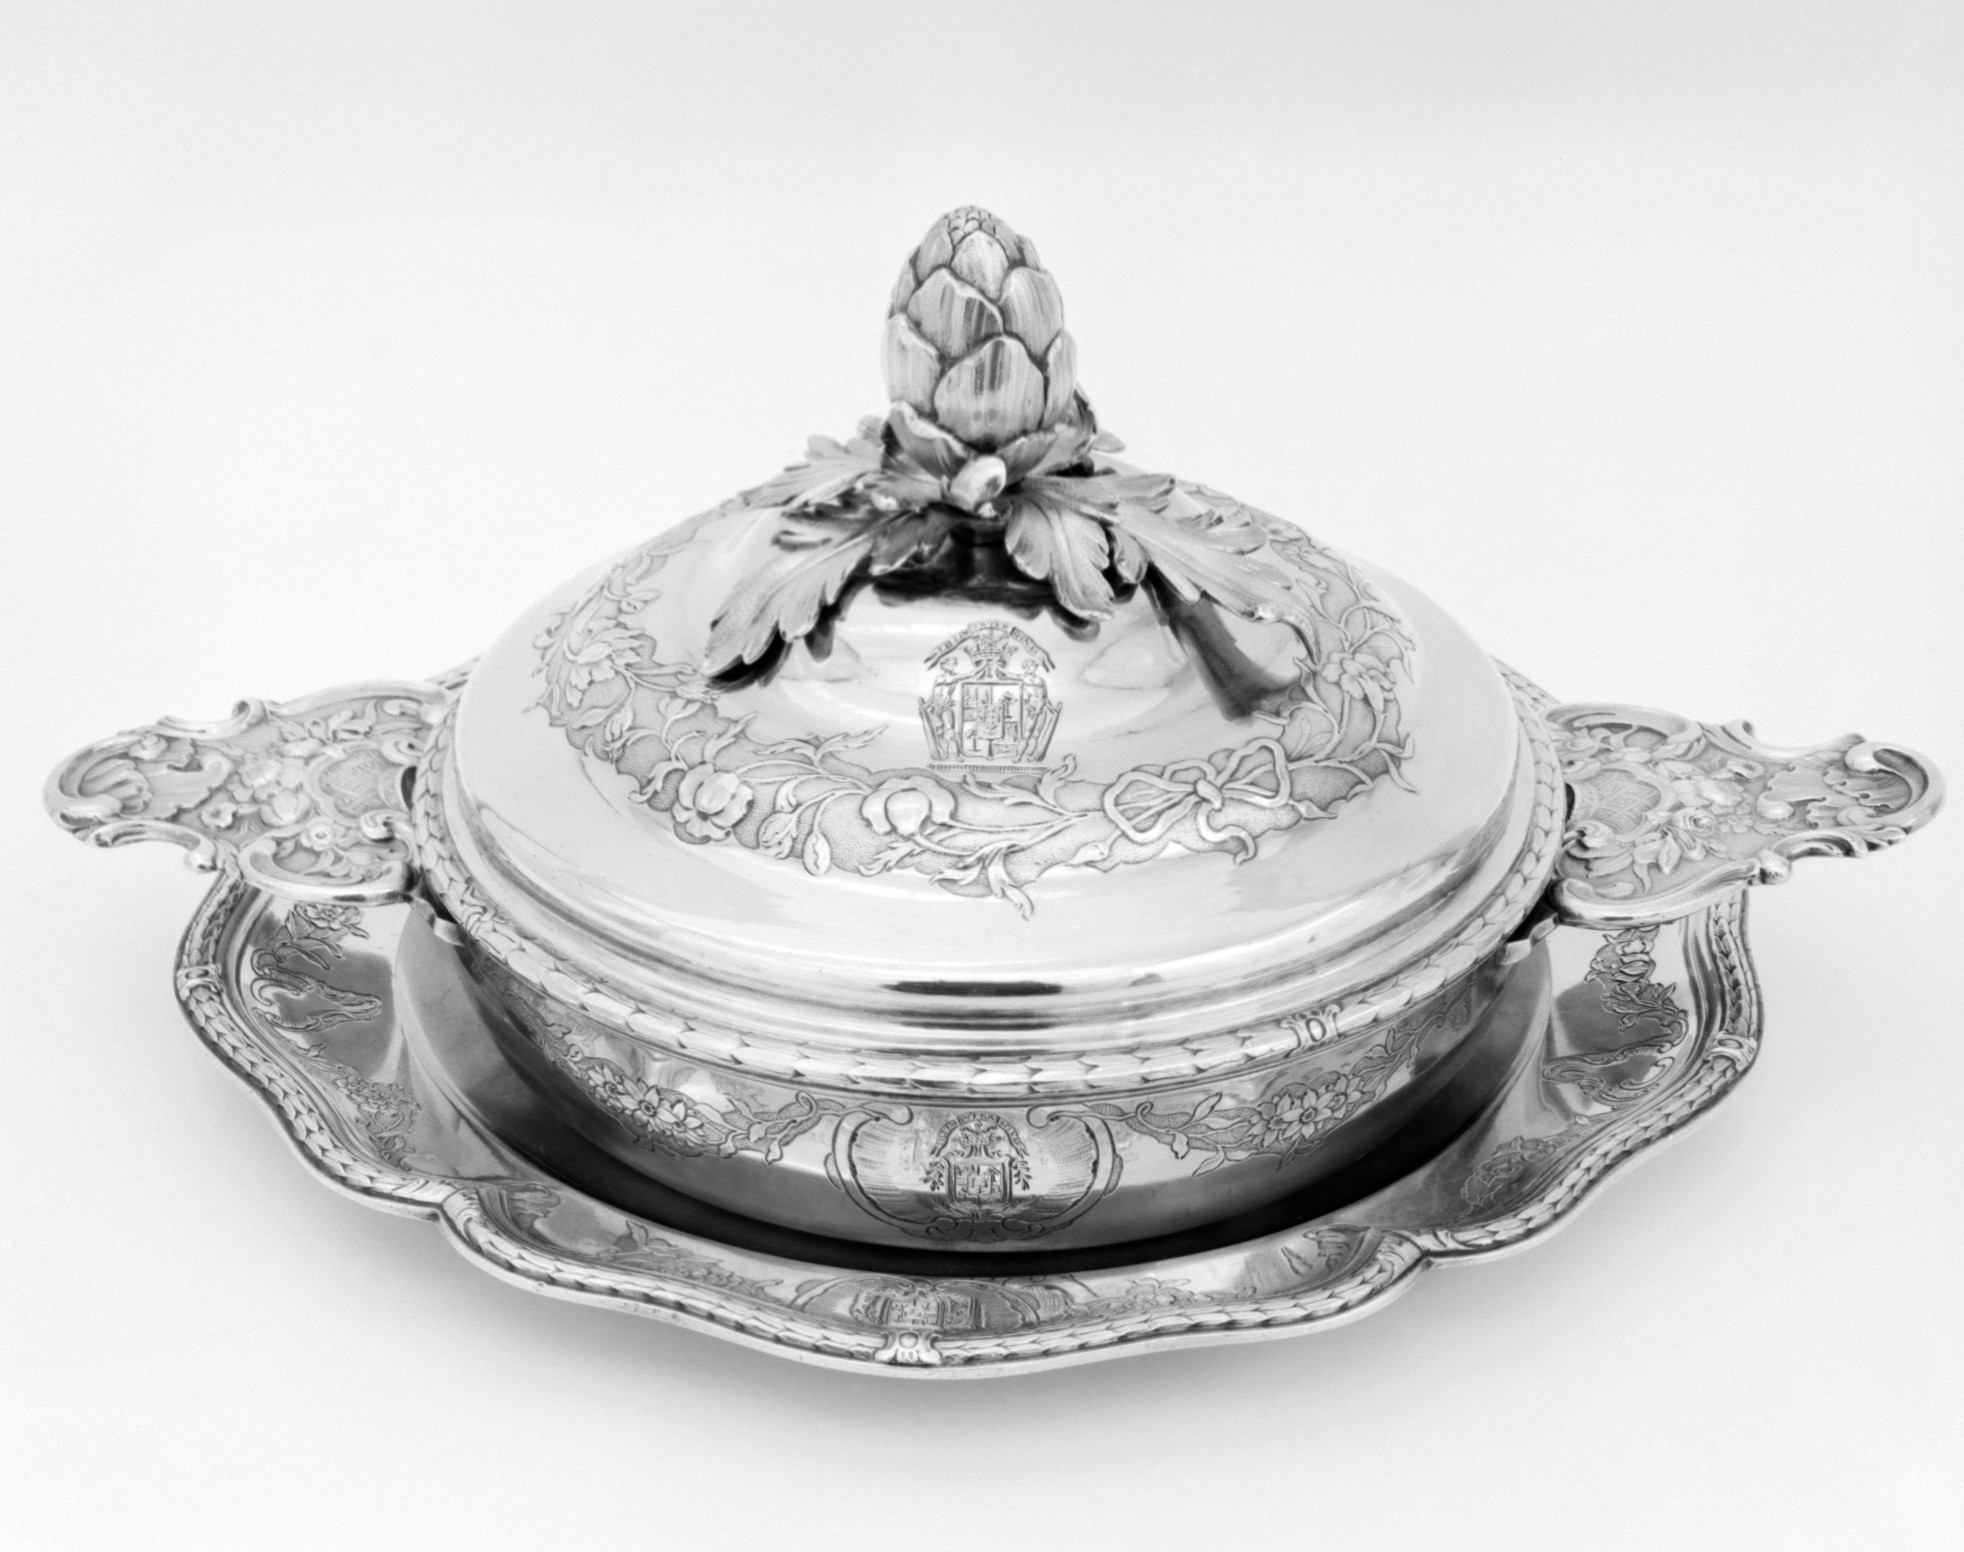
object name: broth bowl with cover and stand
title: Broth bowl with cover and stand (part of a traveling set)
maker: louis imlin iii the younger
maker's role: maker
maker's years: 1716-1798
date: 1768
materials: silver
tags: coat of arms